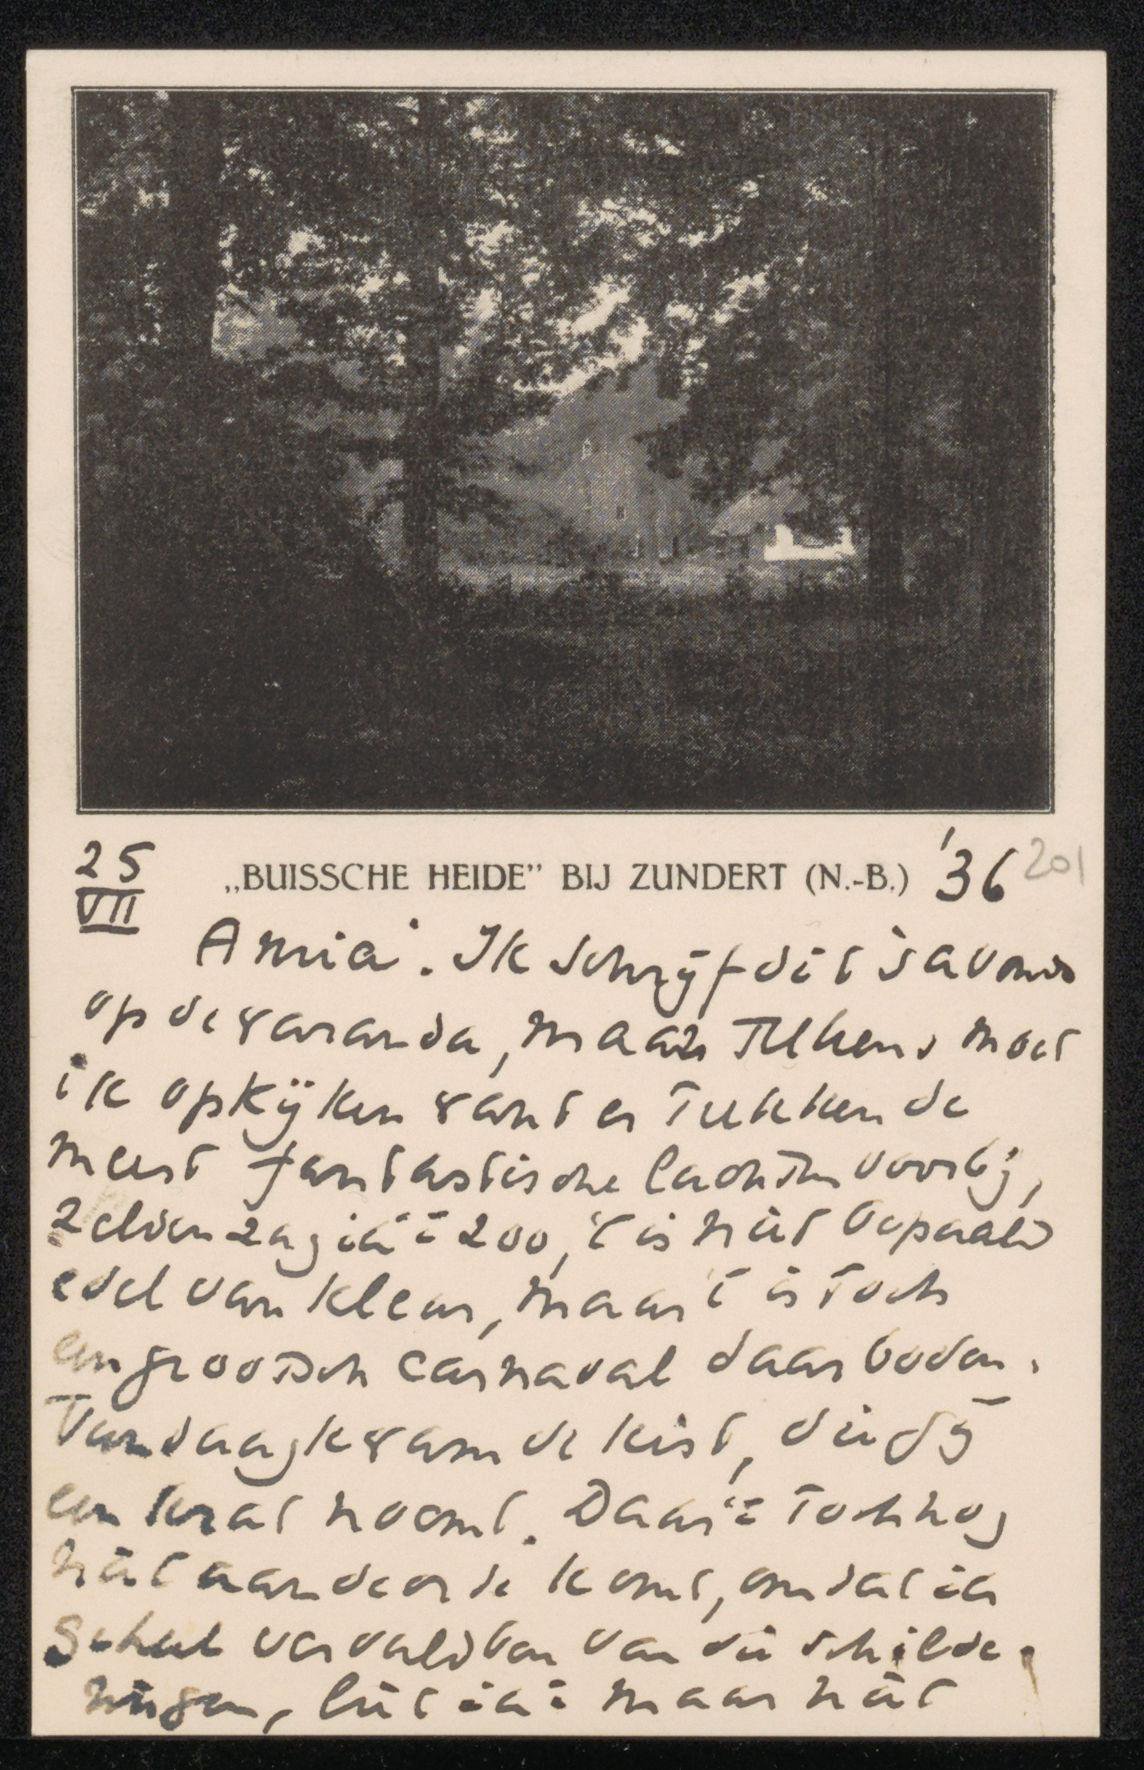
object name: postcard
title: Briefkaart aan Willem Bogtman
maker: richard nicolaüs roland holst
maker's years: 1868-1938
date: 1936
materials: cardboard, ink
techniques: pen, writing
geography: buissche heide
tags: ab bogtman, willem bogtman, gouda, draughtsman, dirck pietersz. crabeth, henriëtte roland holst-van der schalk, applied arts, arts and crafts; industrial design